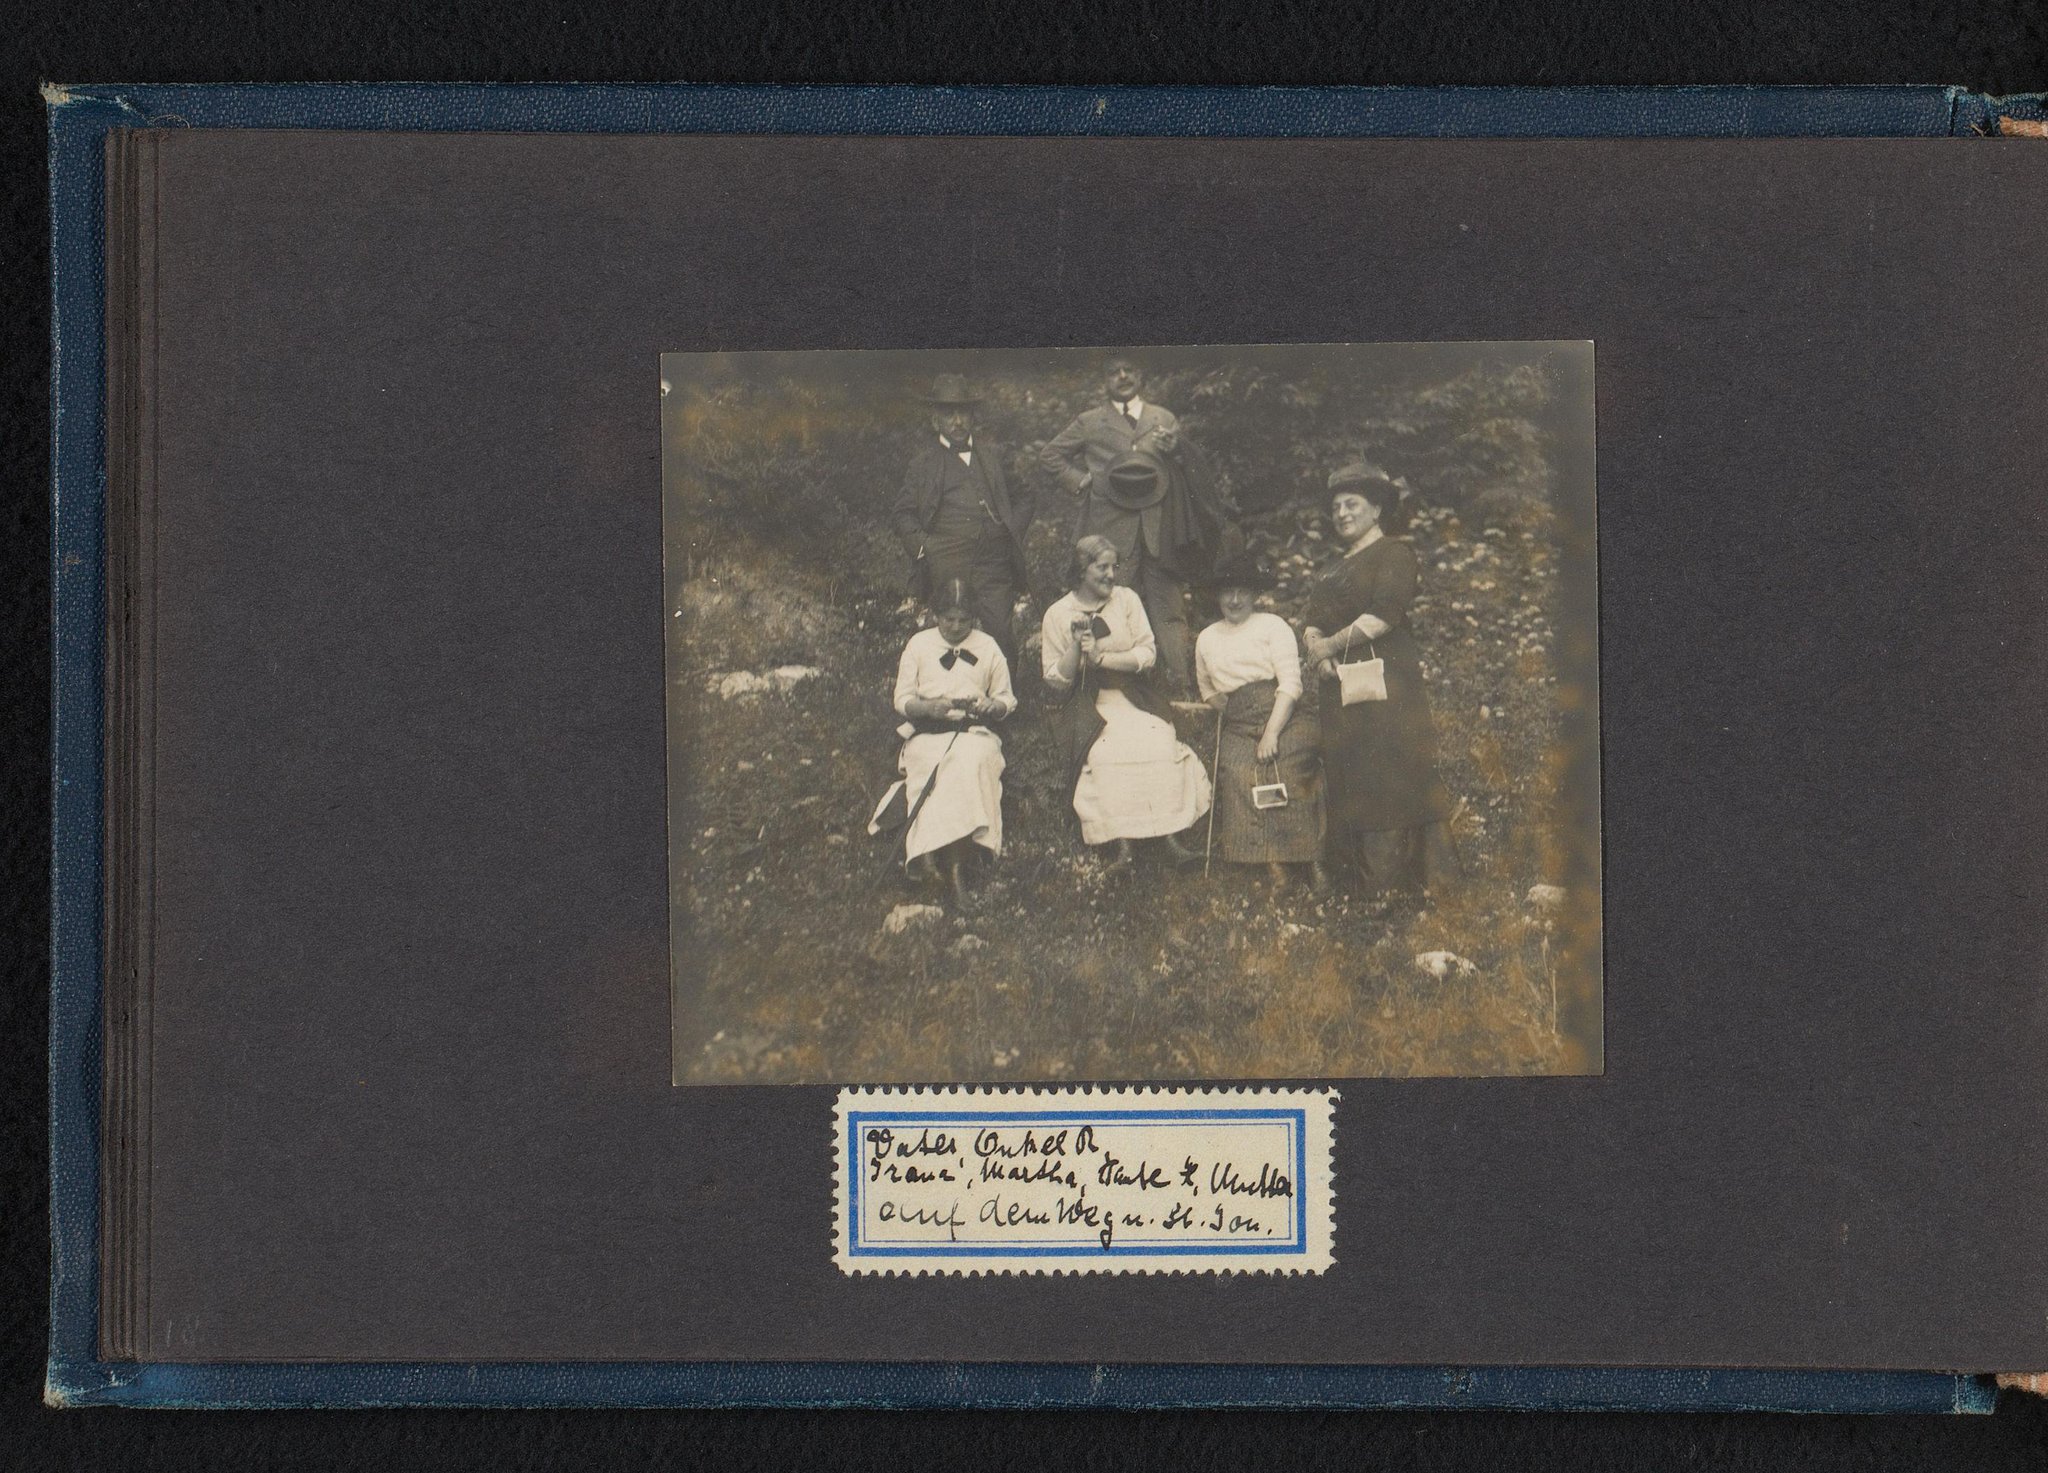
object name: photograph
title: Bergwandeling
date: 1913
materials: paper, photographic support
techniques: gelatin silver print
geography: switzerland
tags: else wachenheimer-moos, the family travelling, on holiday, walking, hiking (recreation), switzerland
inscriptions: inscription: ‘Vater, Onkel R, Franc., Marthe, Tante Z, Ursulla / auf dem Weg u. St. Jon.’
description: Albumblad met een foto van een gezelschap rustend tijdens een wandeling, in Zwitserland. Onderdeel van het fotoalbum van Else Wachenheimer-Moos en haar broers Arthur en Willy Moos en anderen in de periode 1913-1918.